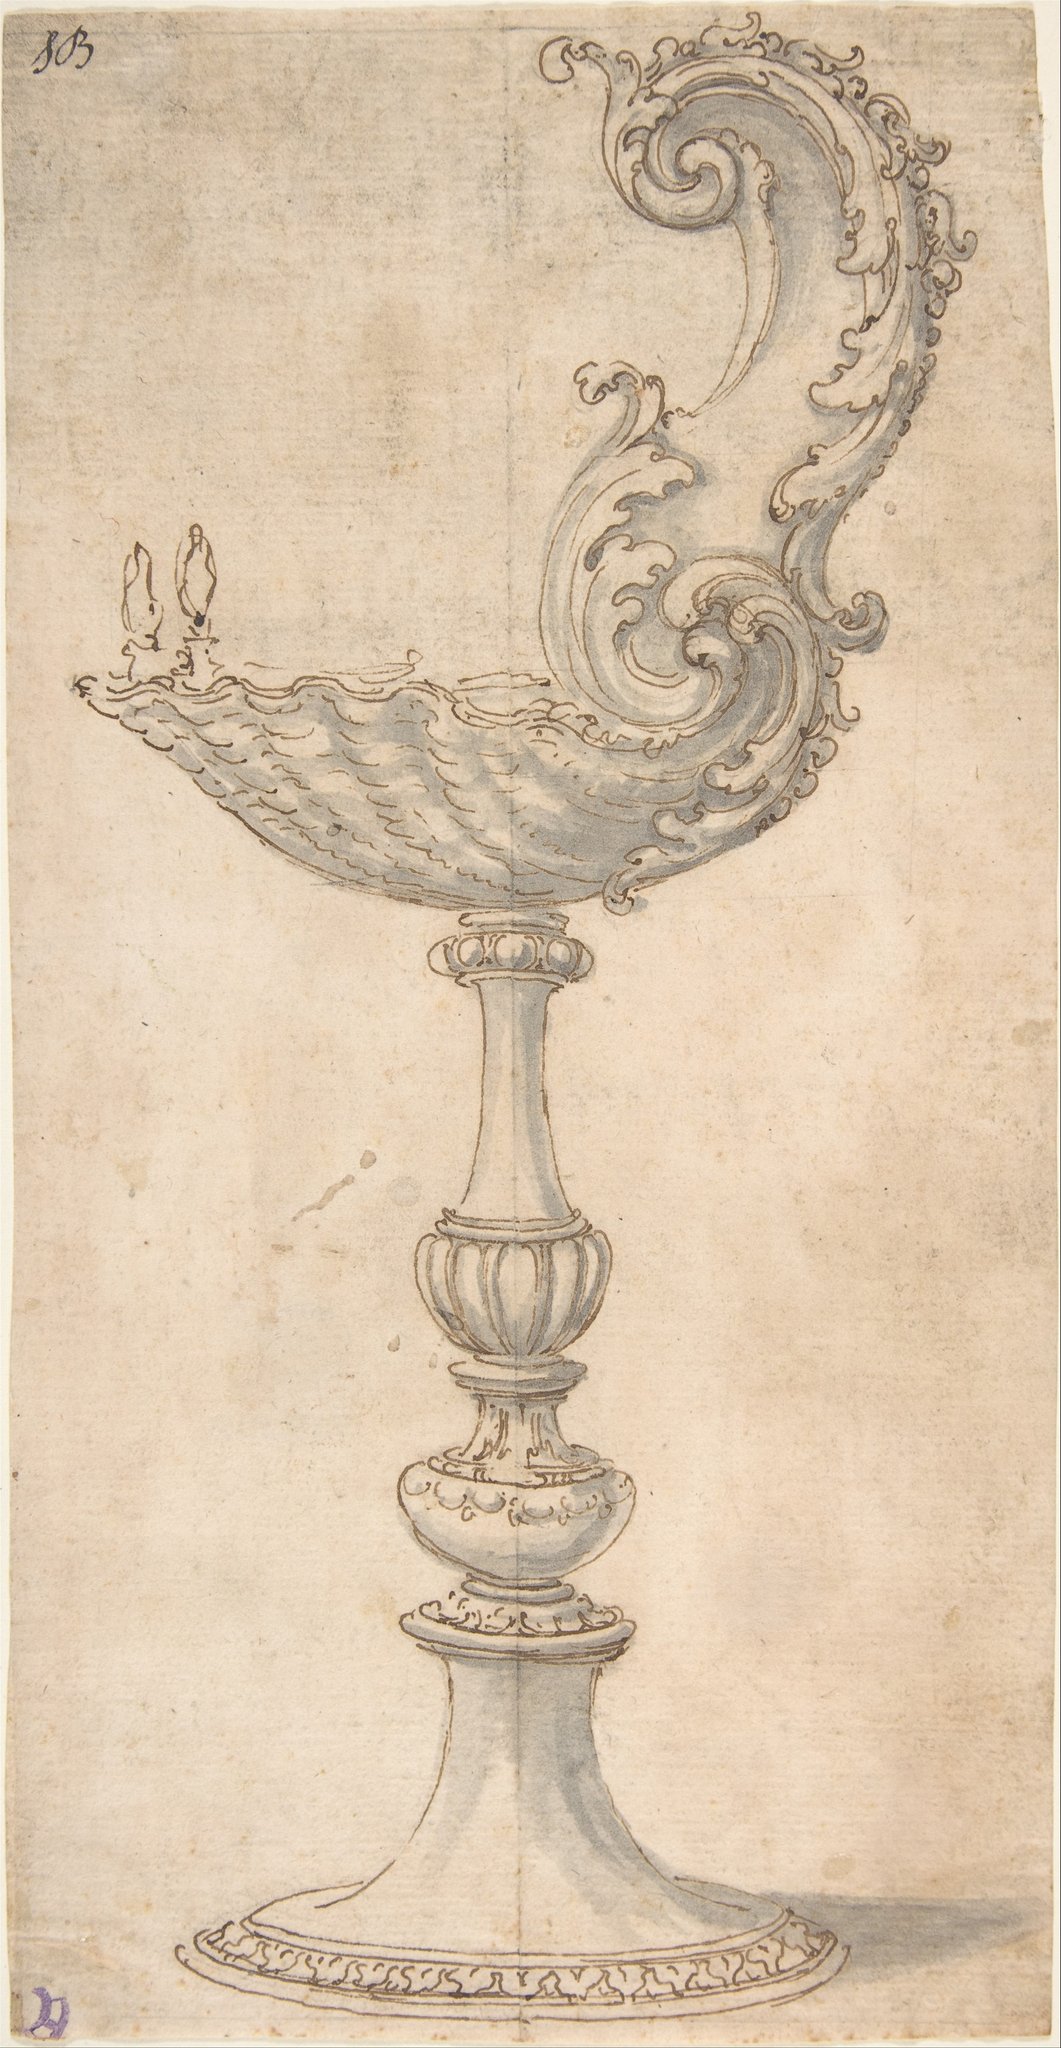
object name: drawing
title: Design for a Cup or Reliquary Composed of a Shell and S-Volute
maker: giovanni battista foggini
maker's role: artist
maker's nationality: italian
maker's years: 1652-1725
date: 1672-1725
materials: graphite, ink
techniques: brush, pen, wash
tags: shells,reliquaries